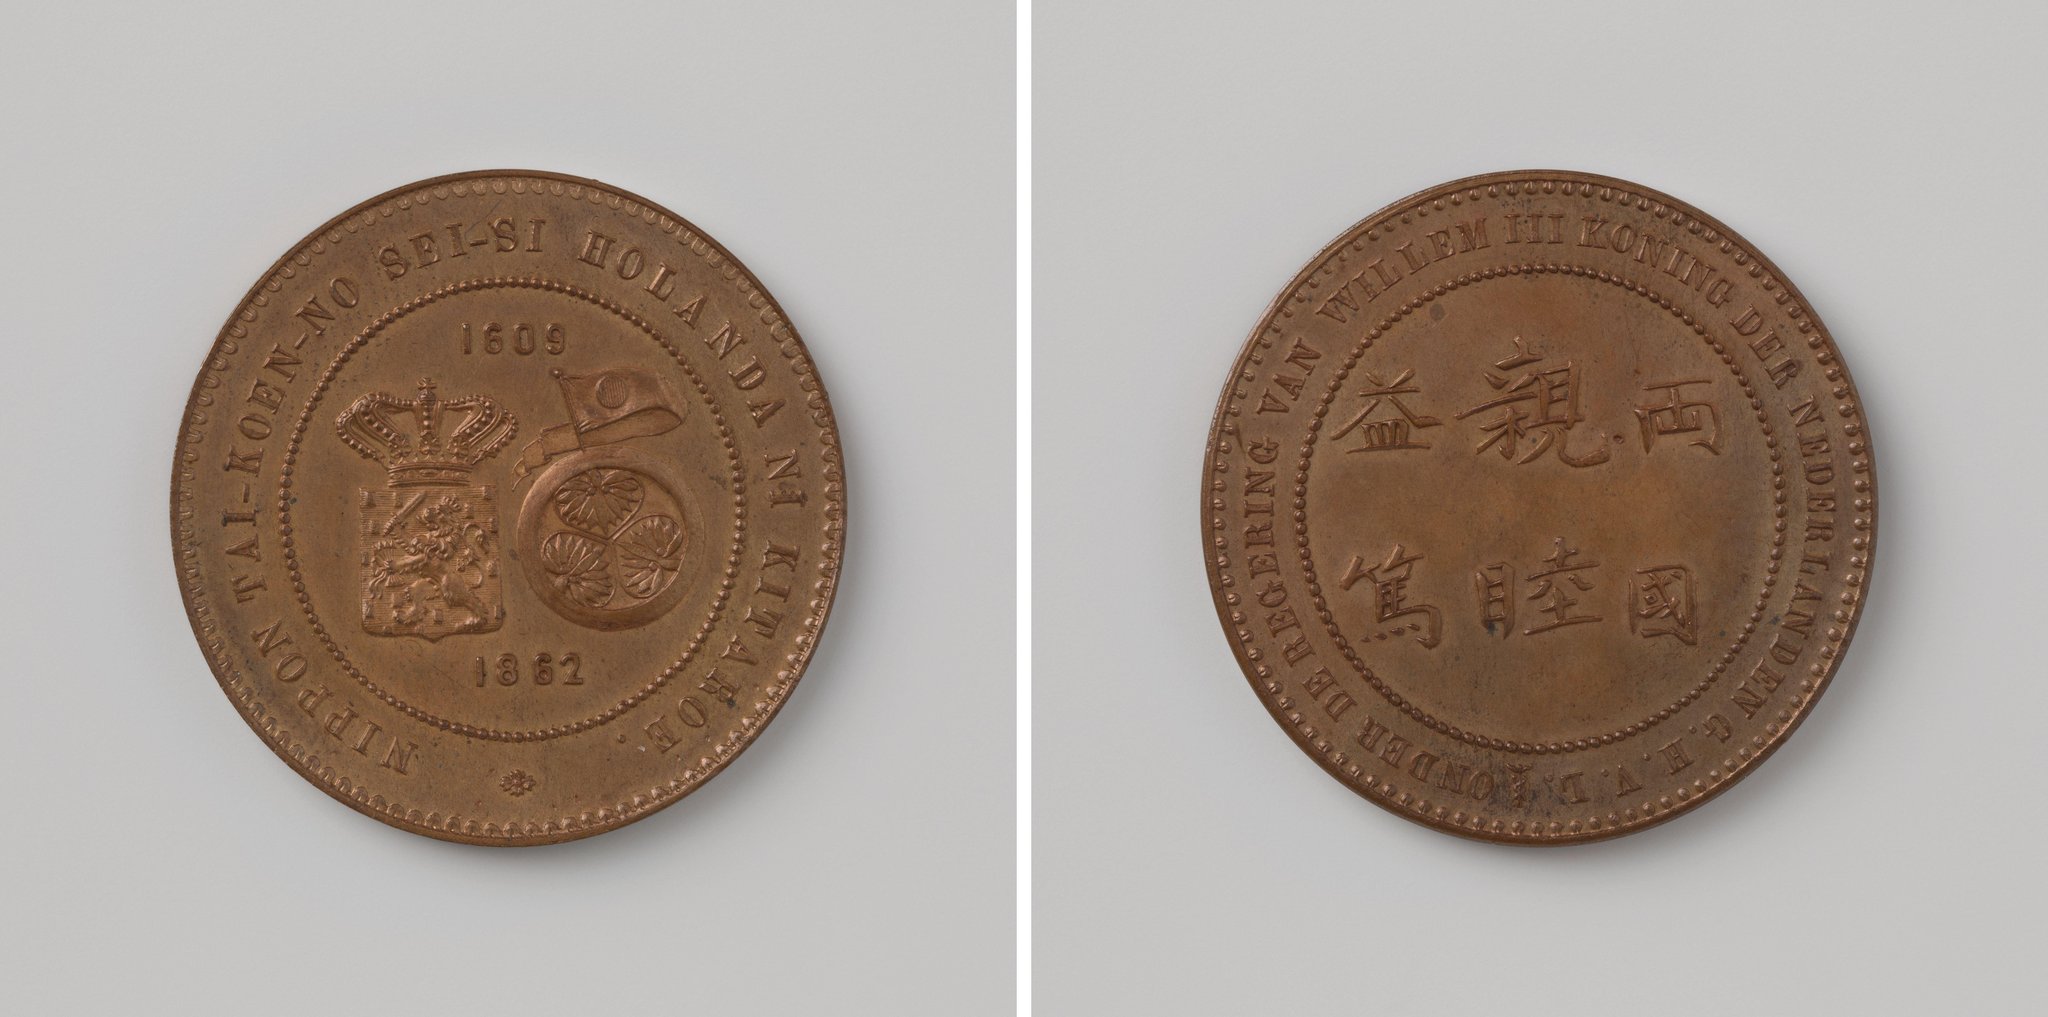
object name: history medal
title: Bezoek van het eerste Japanse gezantschap in Nederland aan de Rijksmunt te Utrecht op 15 juli 1862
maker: david van der kellen (1804-1879)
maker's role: die cutter, draughtsman, print maker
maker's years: 1804-1879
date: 1862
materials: bronze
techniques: striking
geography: utrecht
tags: netherlands, utrecht, japan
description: Ter gelegenheid van het bezoek aan Nederland van een Japanse overheidsgezantschap werden, toen dit gezelschap op 15 juli 1862 bij de Koninklijke Munt in Utrect was, drie zilveren en een aantal koperen gedenkpenningen geslagen. De zilveren penningen werden aan de Japanse gezanten geschonken, voor de andere aanwezige 'autoriteiten' was een koperen exemplaar beschikbaar. De teksten luiden (in het Japans) 'Nippon Taikoen no sei-si Holanda ni kataroe' (een gezantschap van de grootheer van Japan komt naar Nederland) en op de keerzijde (in Chinese karakters) 'Rijoo koku Sin-boku másu másu' (van beide rijken de vriendschap meer en meer innig').